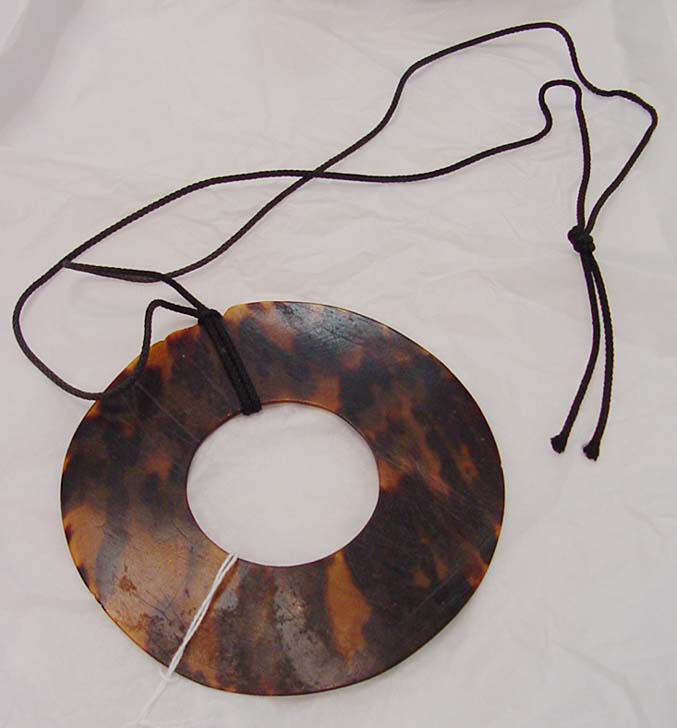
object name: necklace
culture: oceanic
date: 1801-1900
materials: cotton, shell